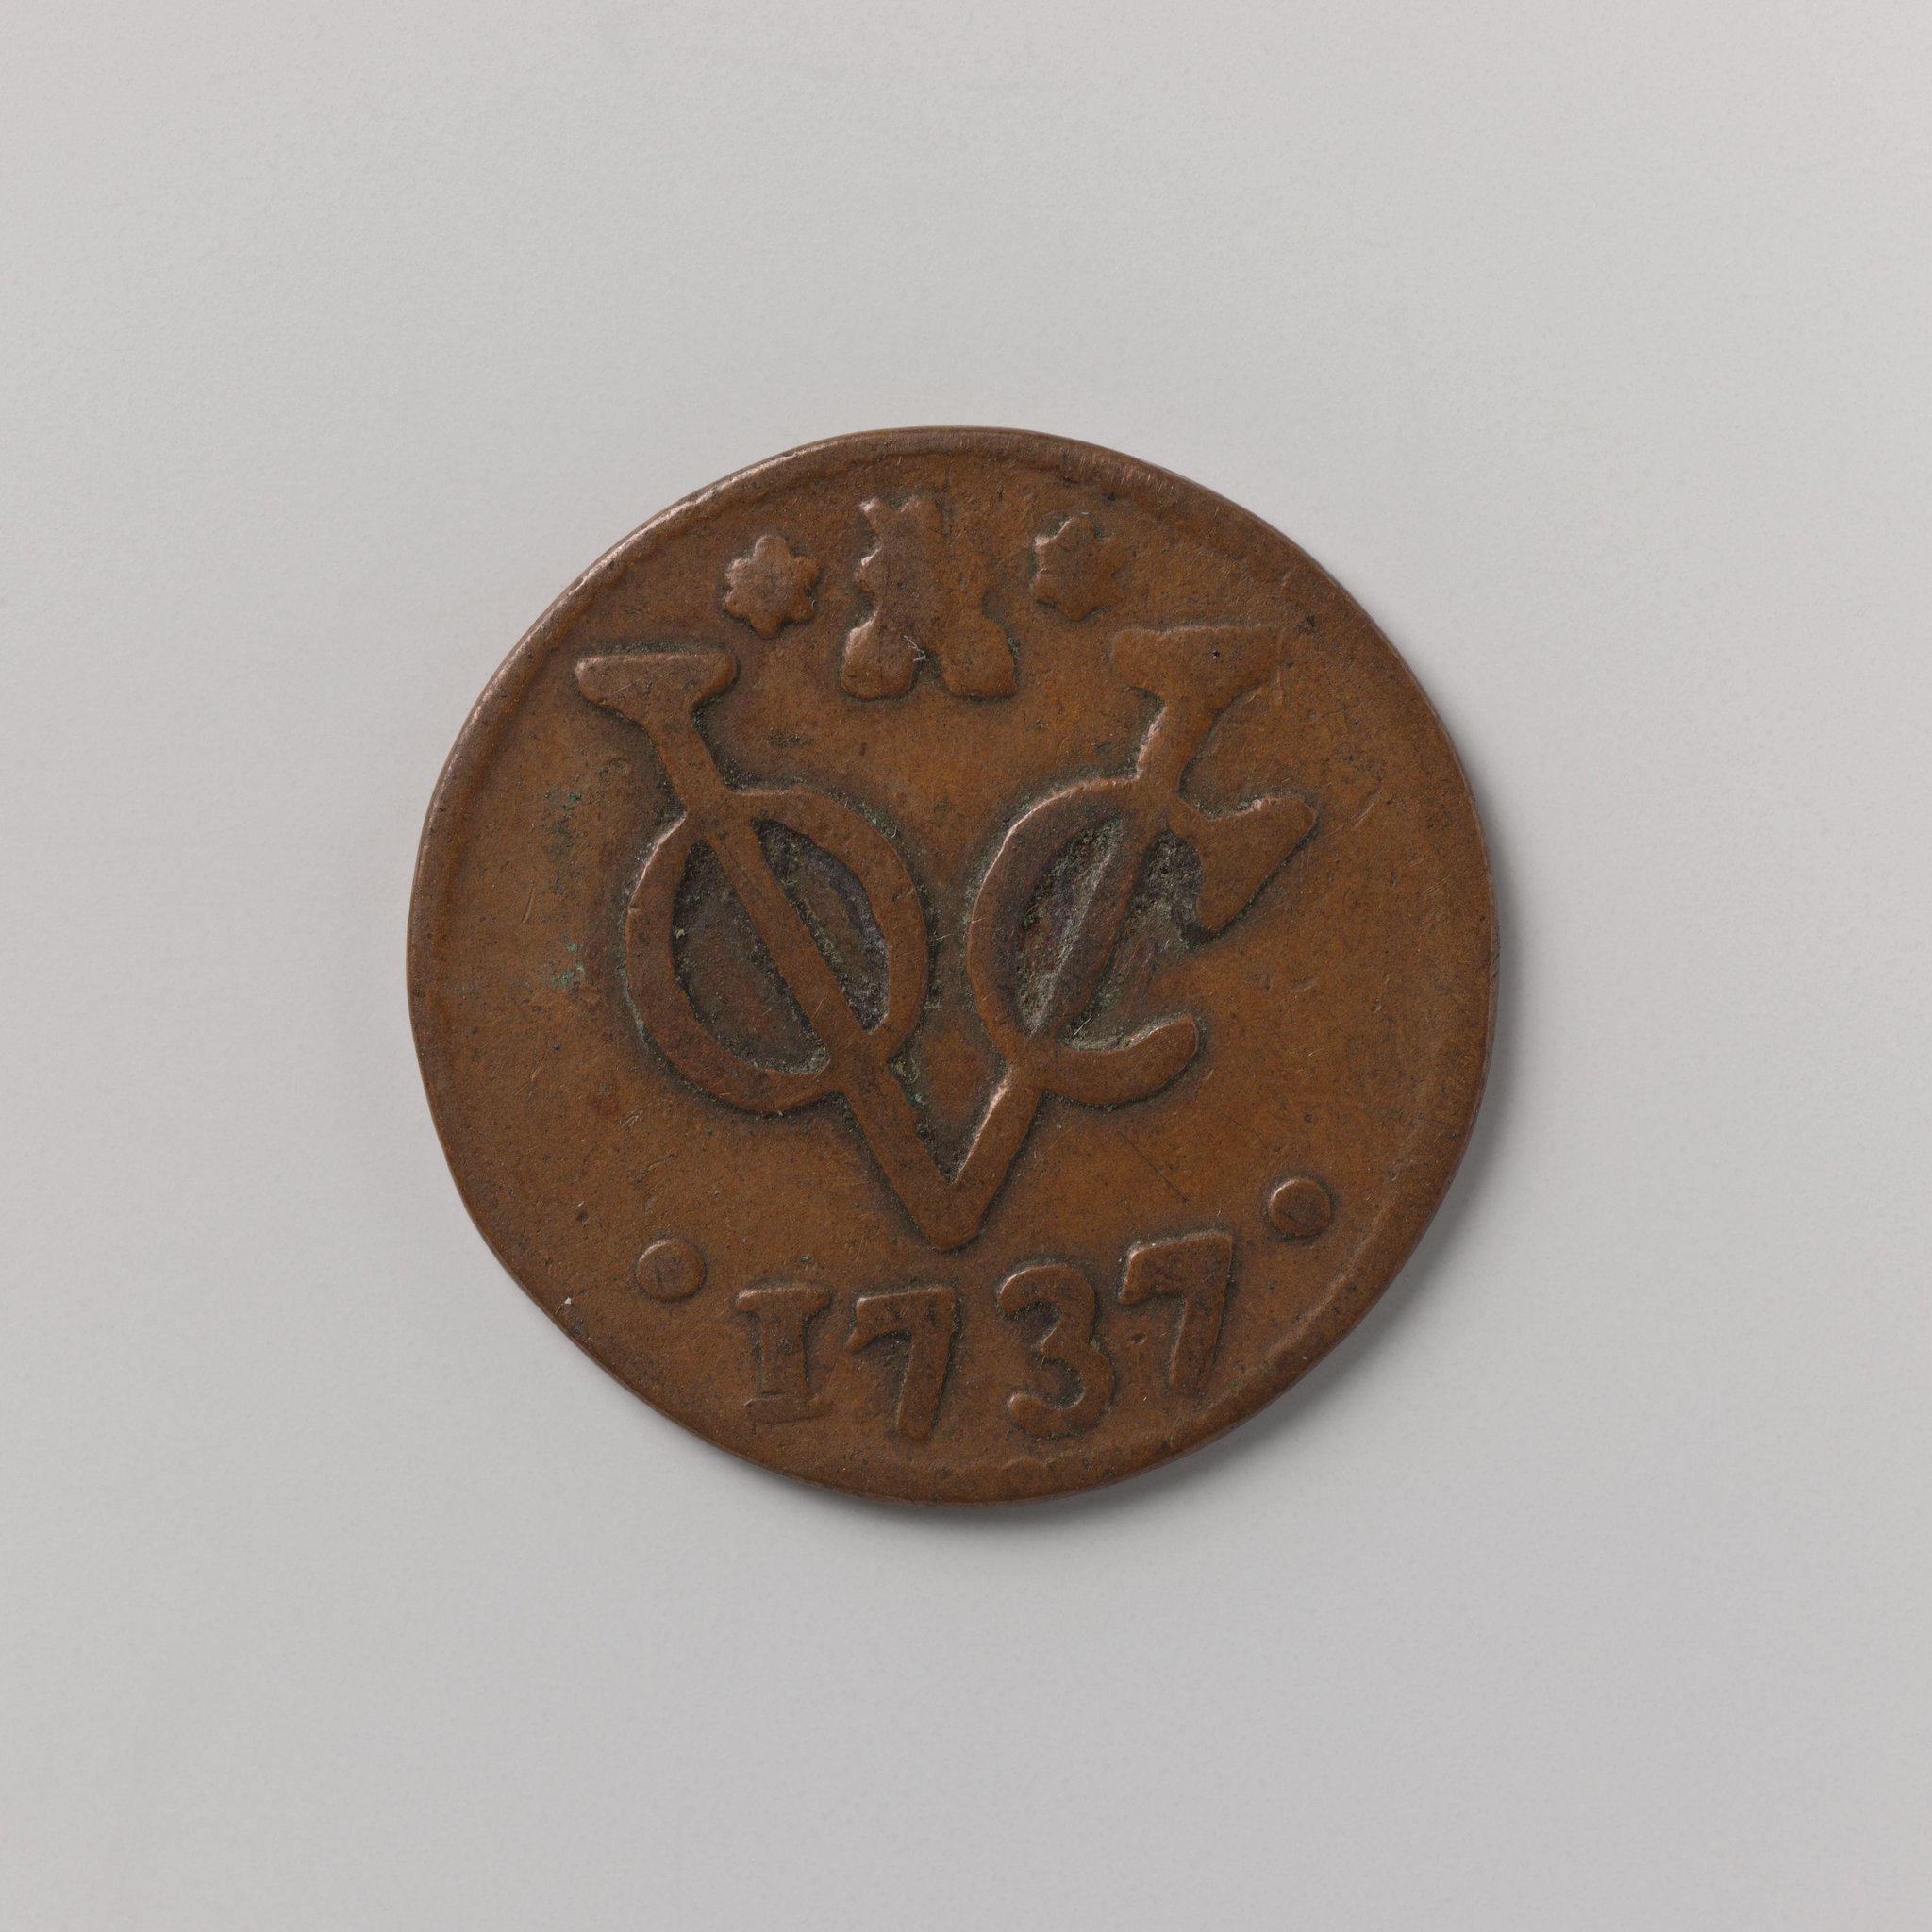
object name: coin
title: Duit van de VOC uit Zeeland, 1737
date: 1737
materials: copper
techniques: striking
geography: middelburg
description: Koperen munt. Voorzijde: gekroond wapenschild van Zeeland. Keerzijde: monogram van de VOC, waarboven muntteken en waaronder jaartal. Gladde rand.